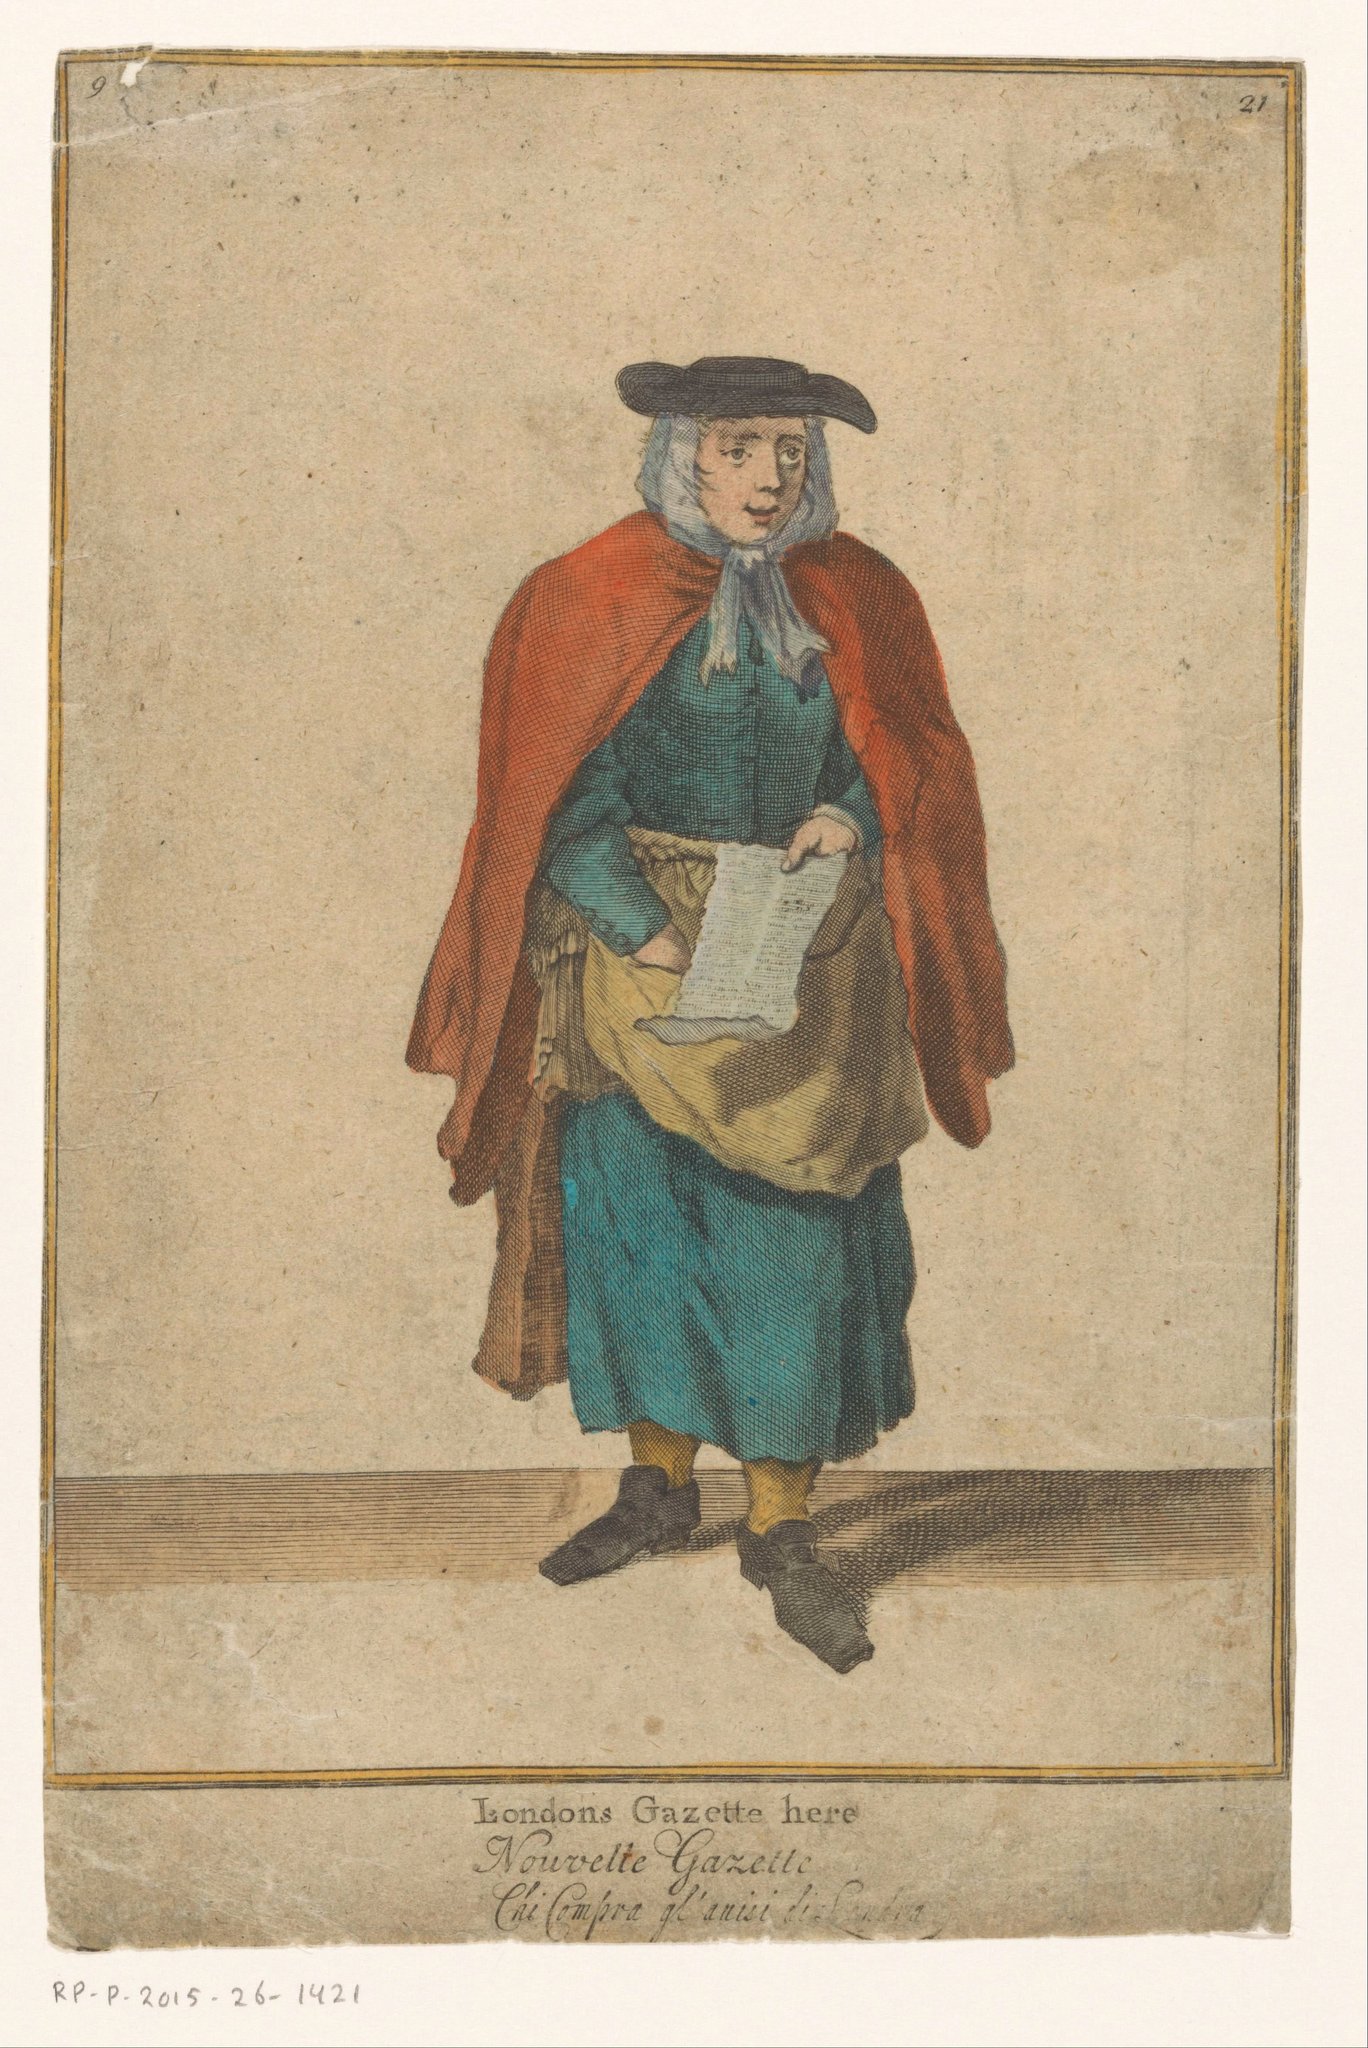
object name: print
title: The Cryes of the City of London Drawne after the Life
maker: Anonymous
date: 1688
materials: paper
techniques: engraving, etching, hand coloring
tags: street-trader, book-shop, bookseller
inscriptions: collector's mark: Lugt 2228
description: Voor het eerst gepubliceerd in 1688. Waarschijnlijk is deze prent afkomstig uit een latere editie.